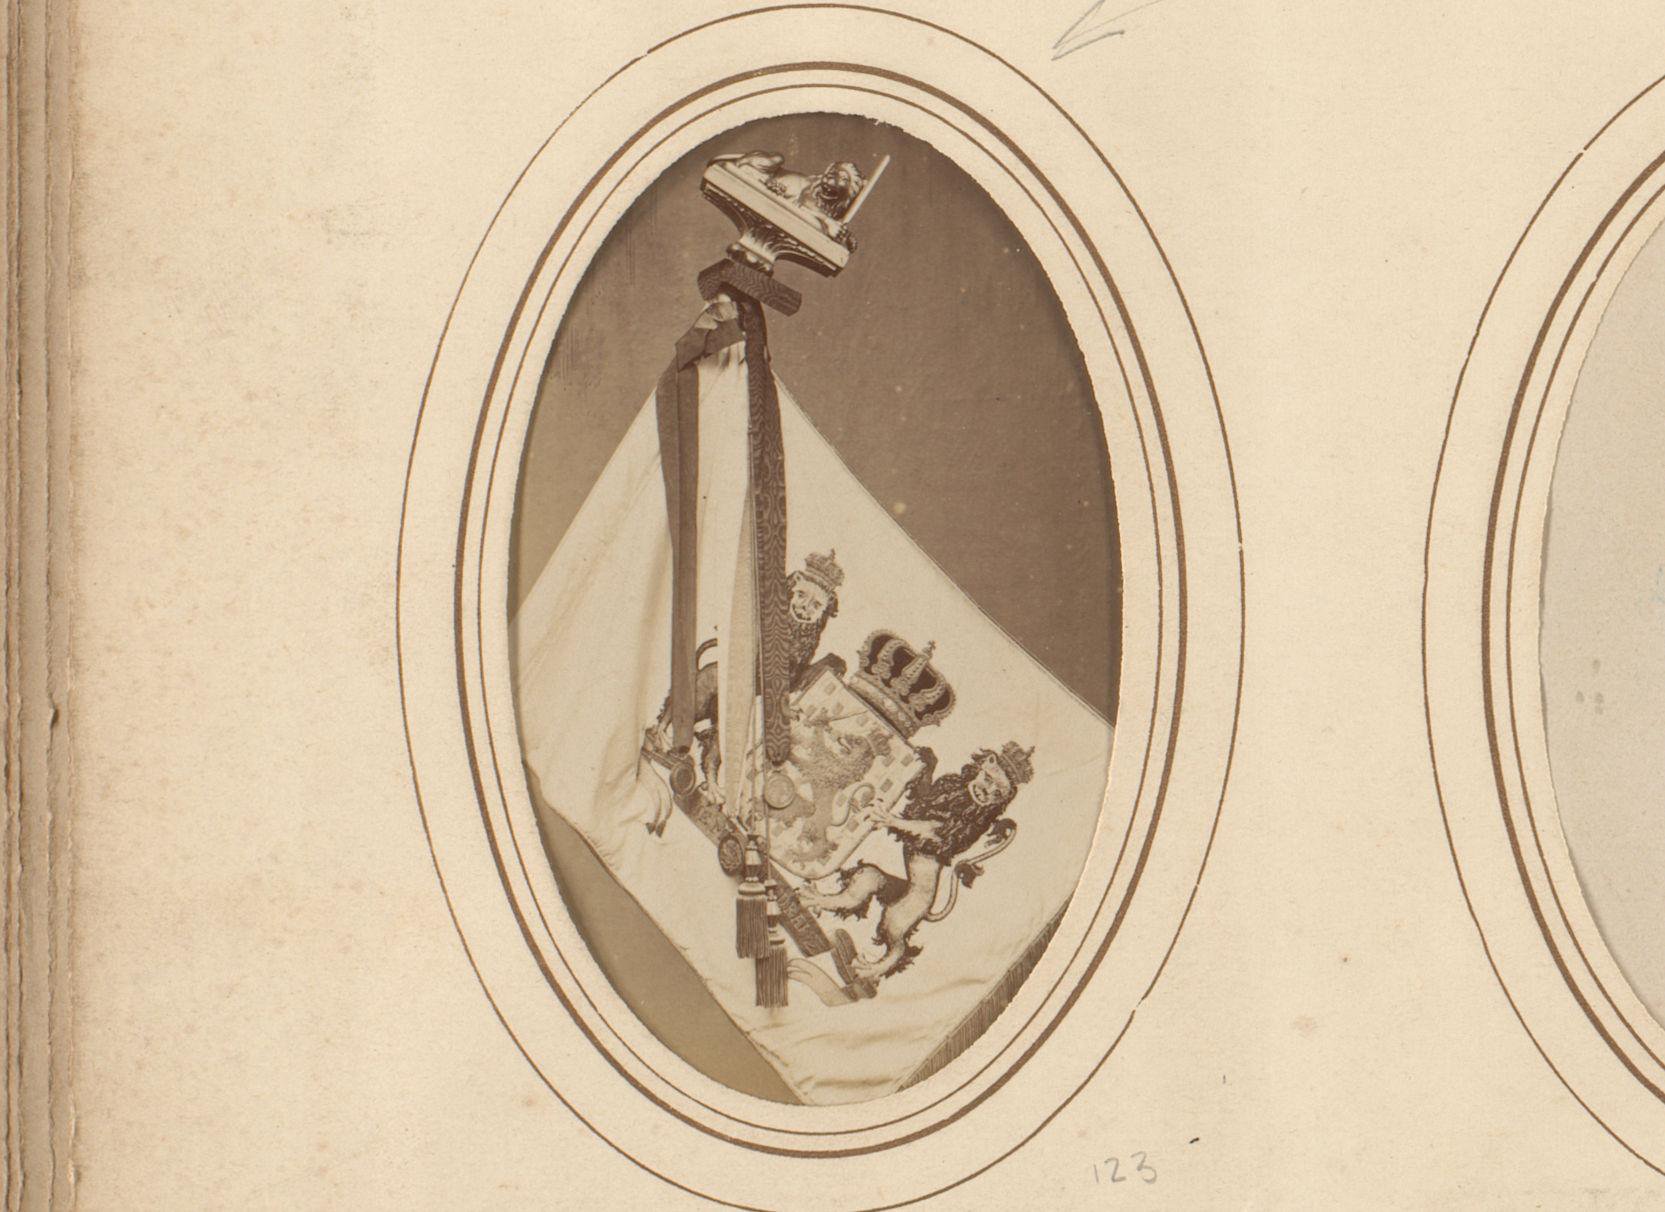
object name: album leaf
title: Vlag met het wapen van Nederland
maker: george lodewijk mulder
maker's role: fotograaf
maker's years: 1841-1920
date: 1865-1880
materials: cardboard, photographic support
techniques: albumen print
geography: utrecht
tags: coat of arms (as symbol of the state, etc.), flag, colours (as symbol of the state, etc.)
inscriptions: name: ‘G.L. Mulder Utrecht’, inscription: ‘Photogr Atelier/ G.L. Mulder/ van Wijckskade H. 326/ Utrecht’